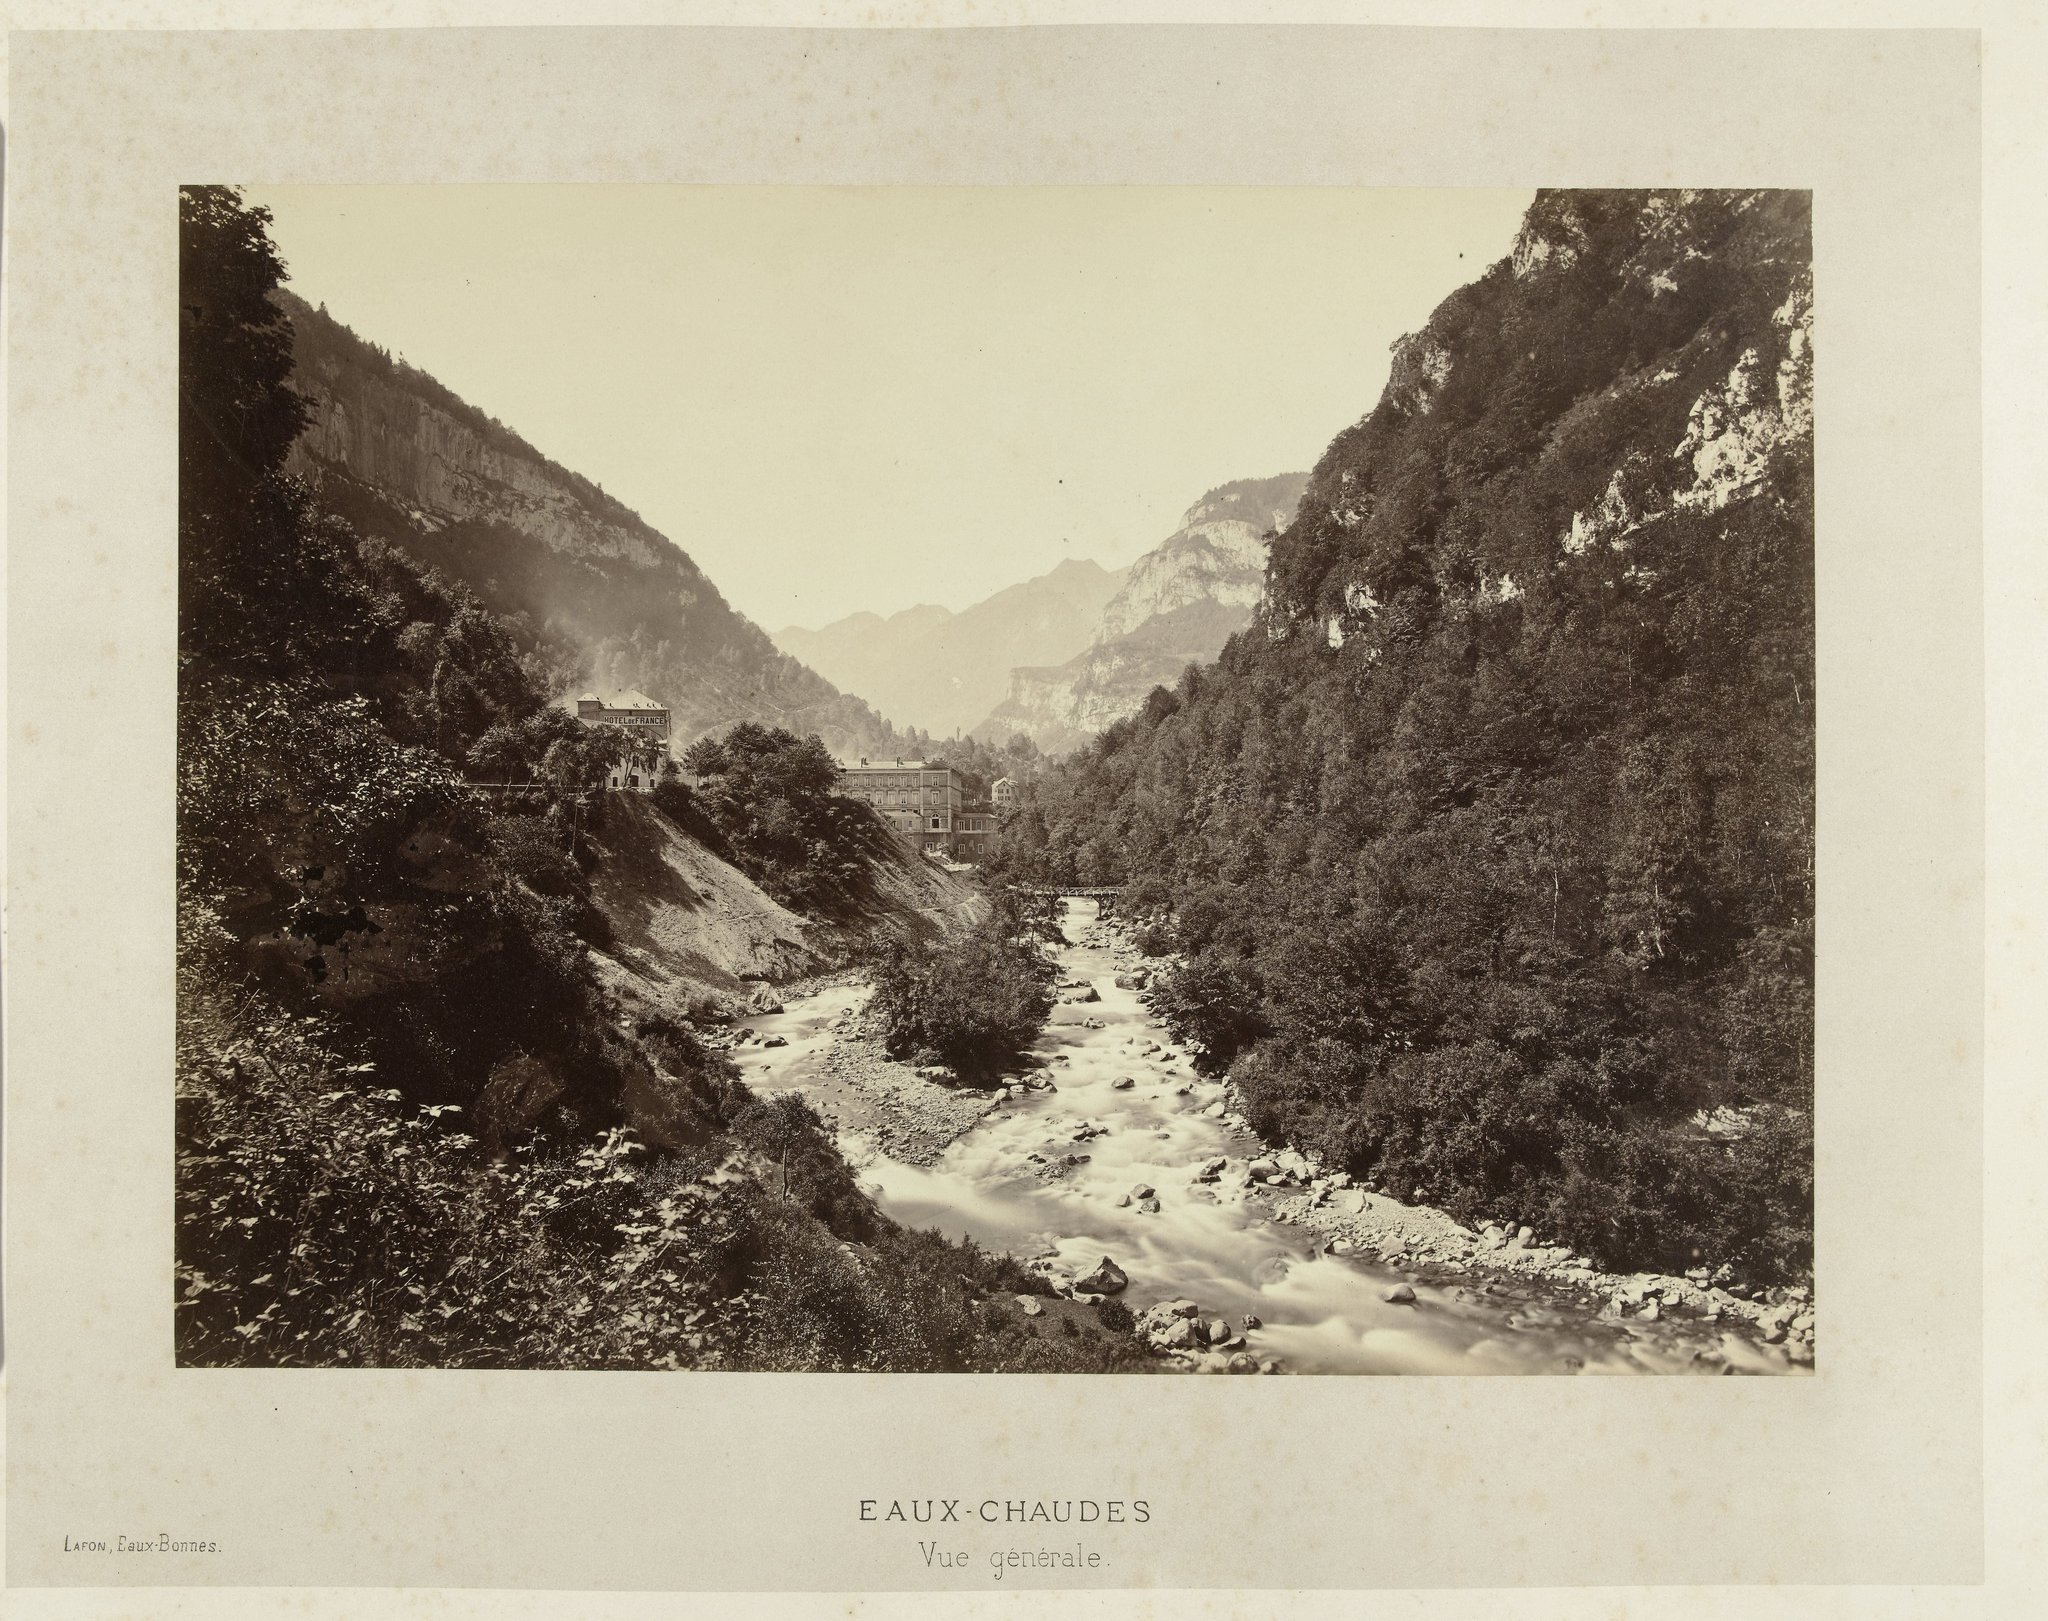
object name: photograph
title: Rivierlandschap in Lafon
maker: lafon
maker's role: publisher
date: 1860-1880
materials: cardboard, photographic support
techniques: albumen print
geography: france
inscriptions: number: ‘1870’, title: ‘EAUX CHAUDES Vue génerale. Lafon, Eaux-Bonnes.’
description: mogelijk aangekocht op de Sotheby's veiling van de Paul F. Walter collectie op 10 mei 2001, lotnr. 116.